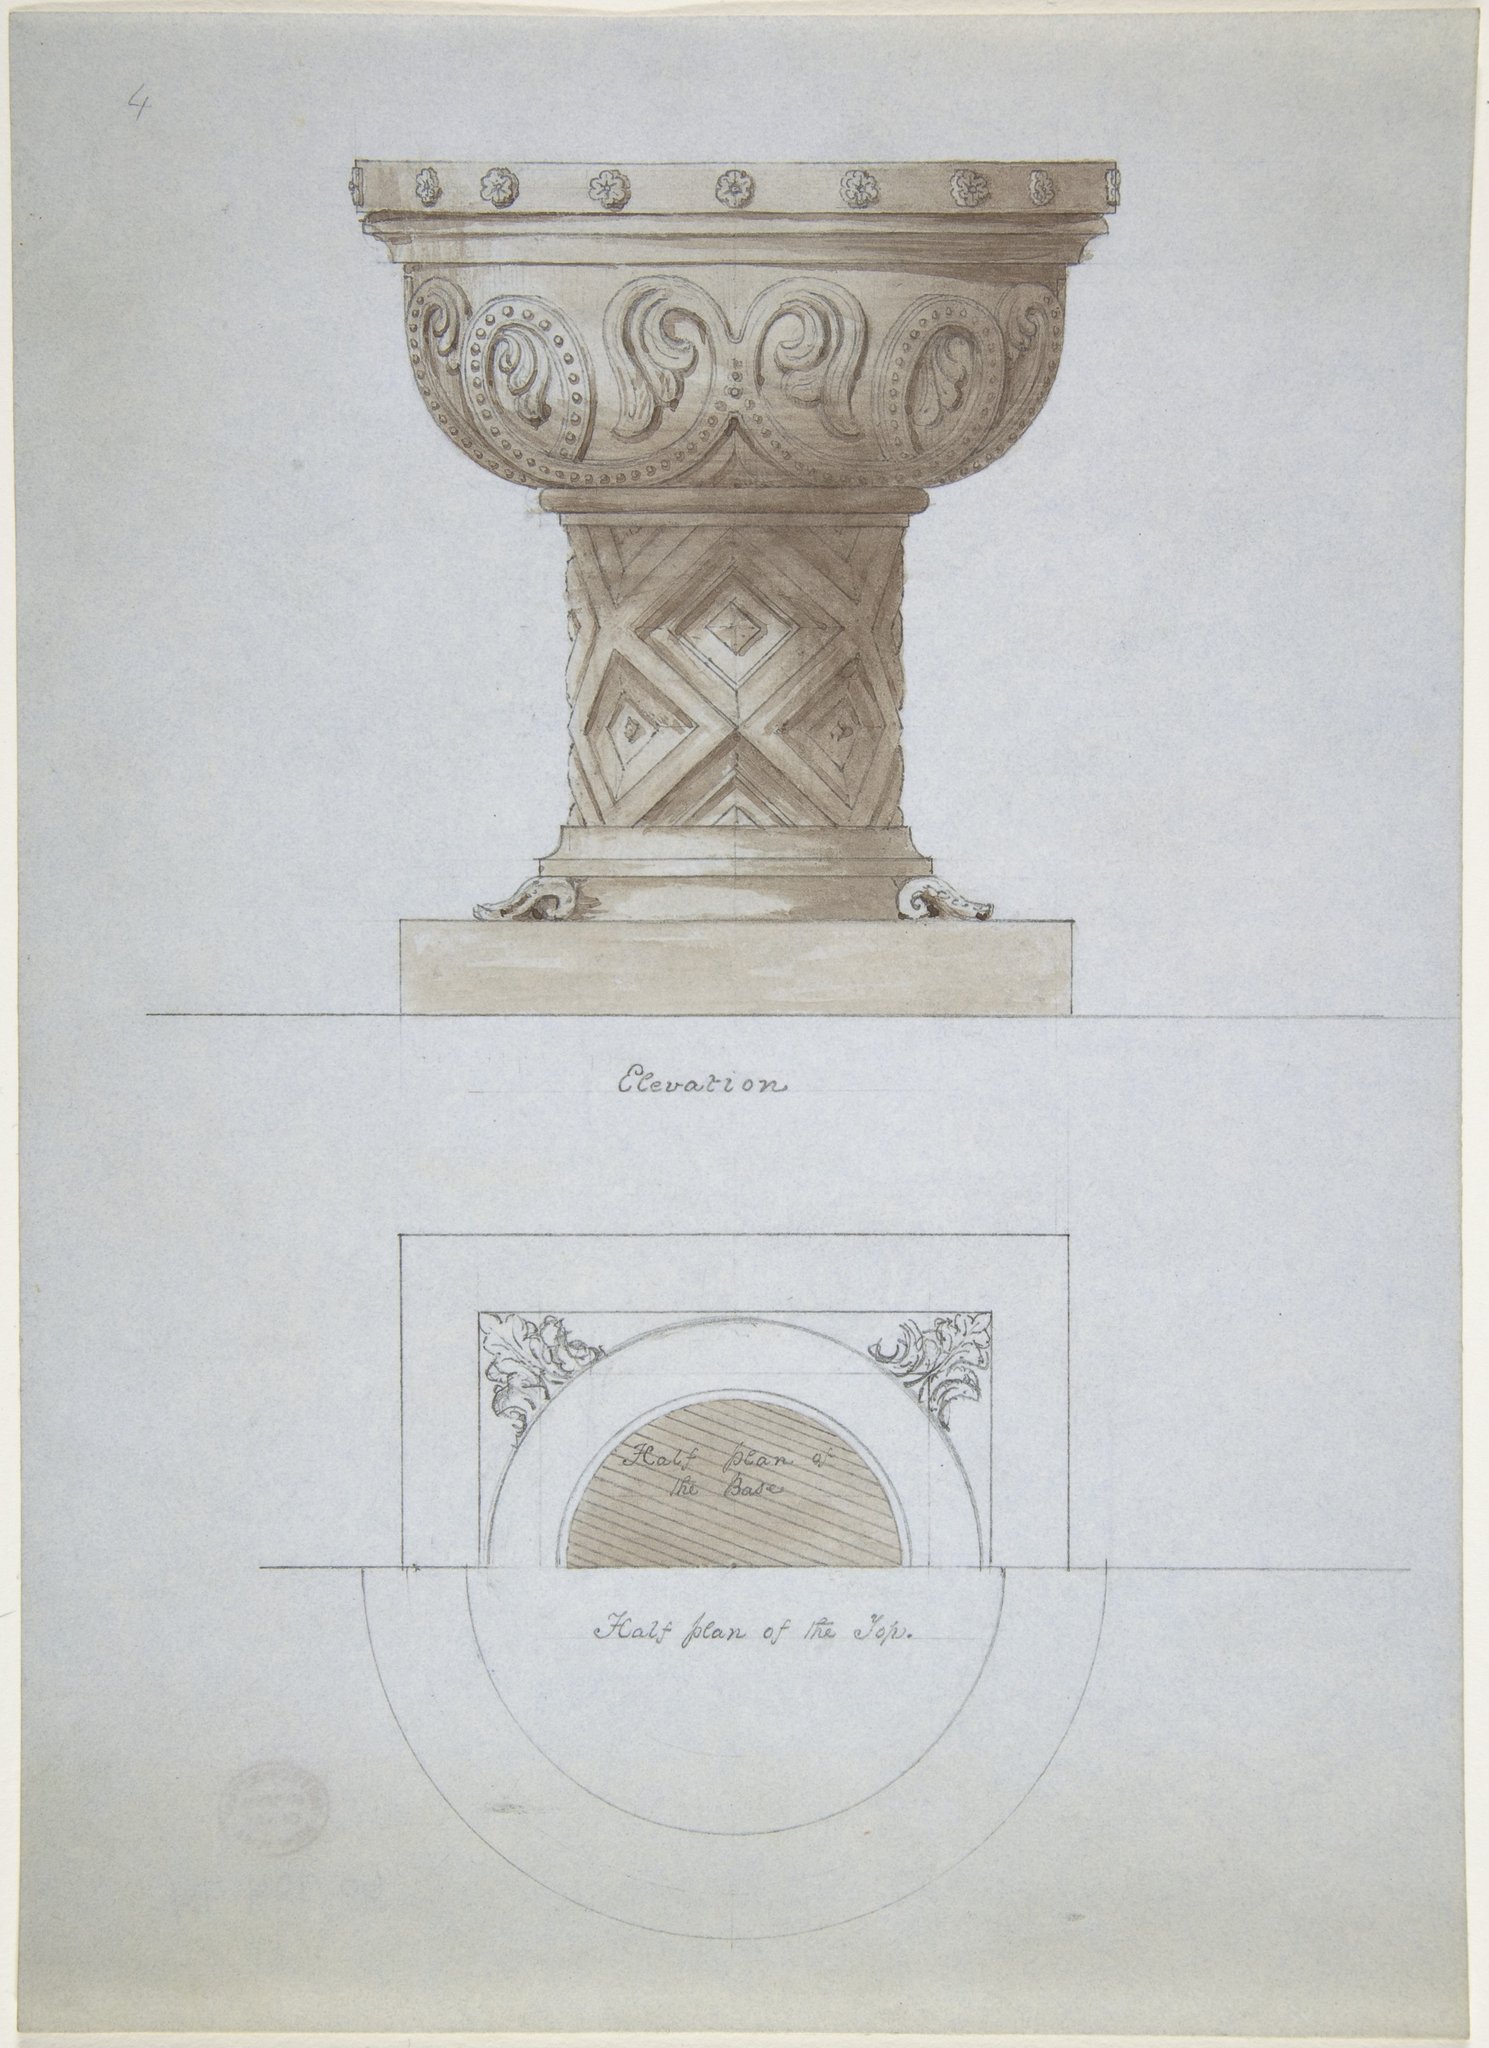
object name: drawing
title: Romanesque Style Font and Plan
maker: anonymous, british, 19th century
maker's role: artist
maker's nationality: british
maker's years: 1800-1900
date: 1834-1866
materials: graphite, ink, paper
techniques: brush, pen, wash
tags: architecture